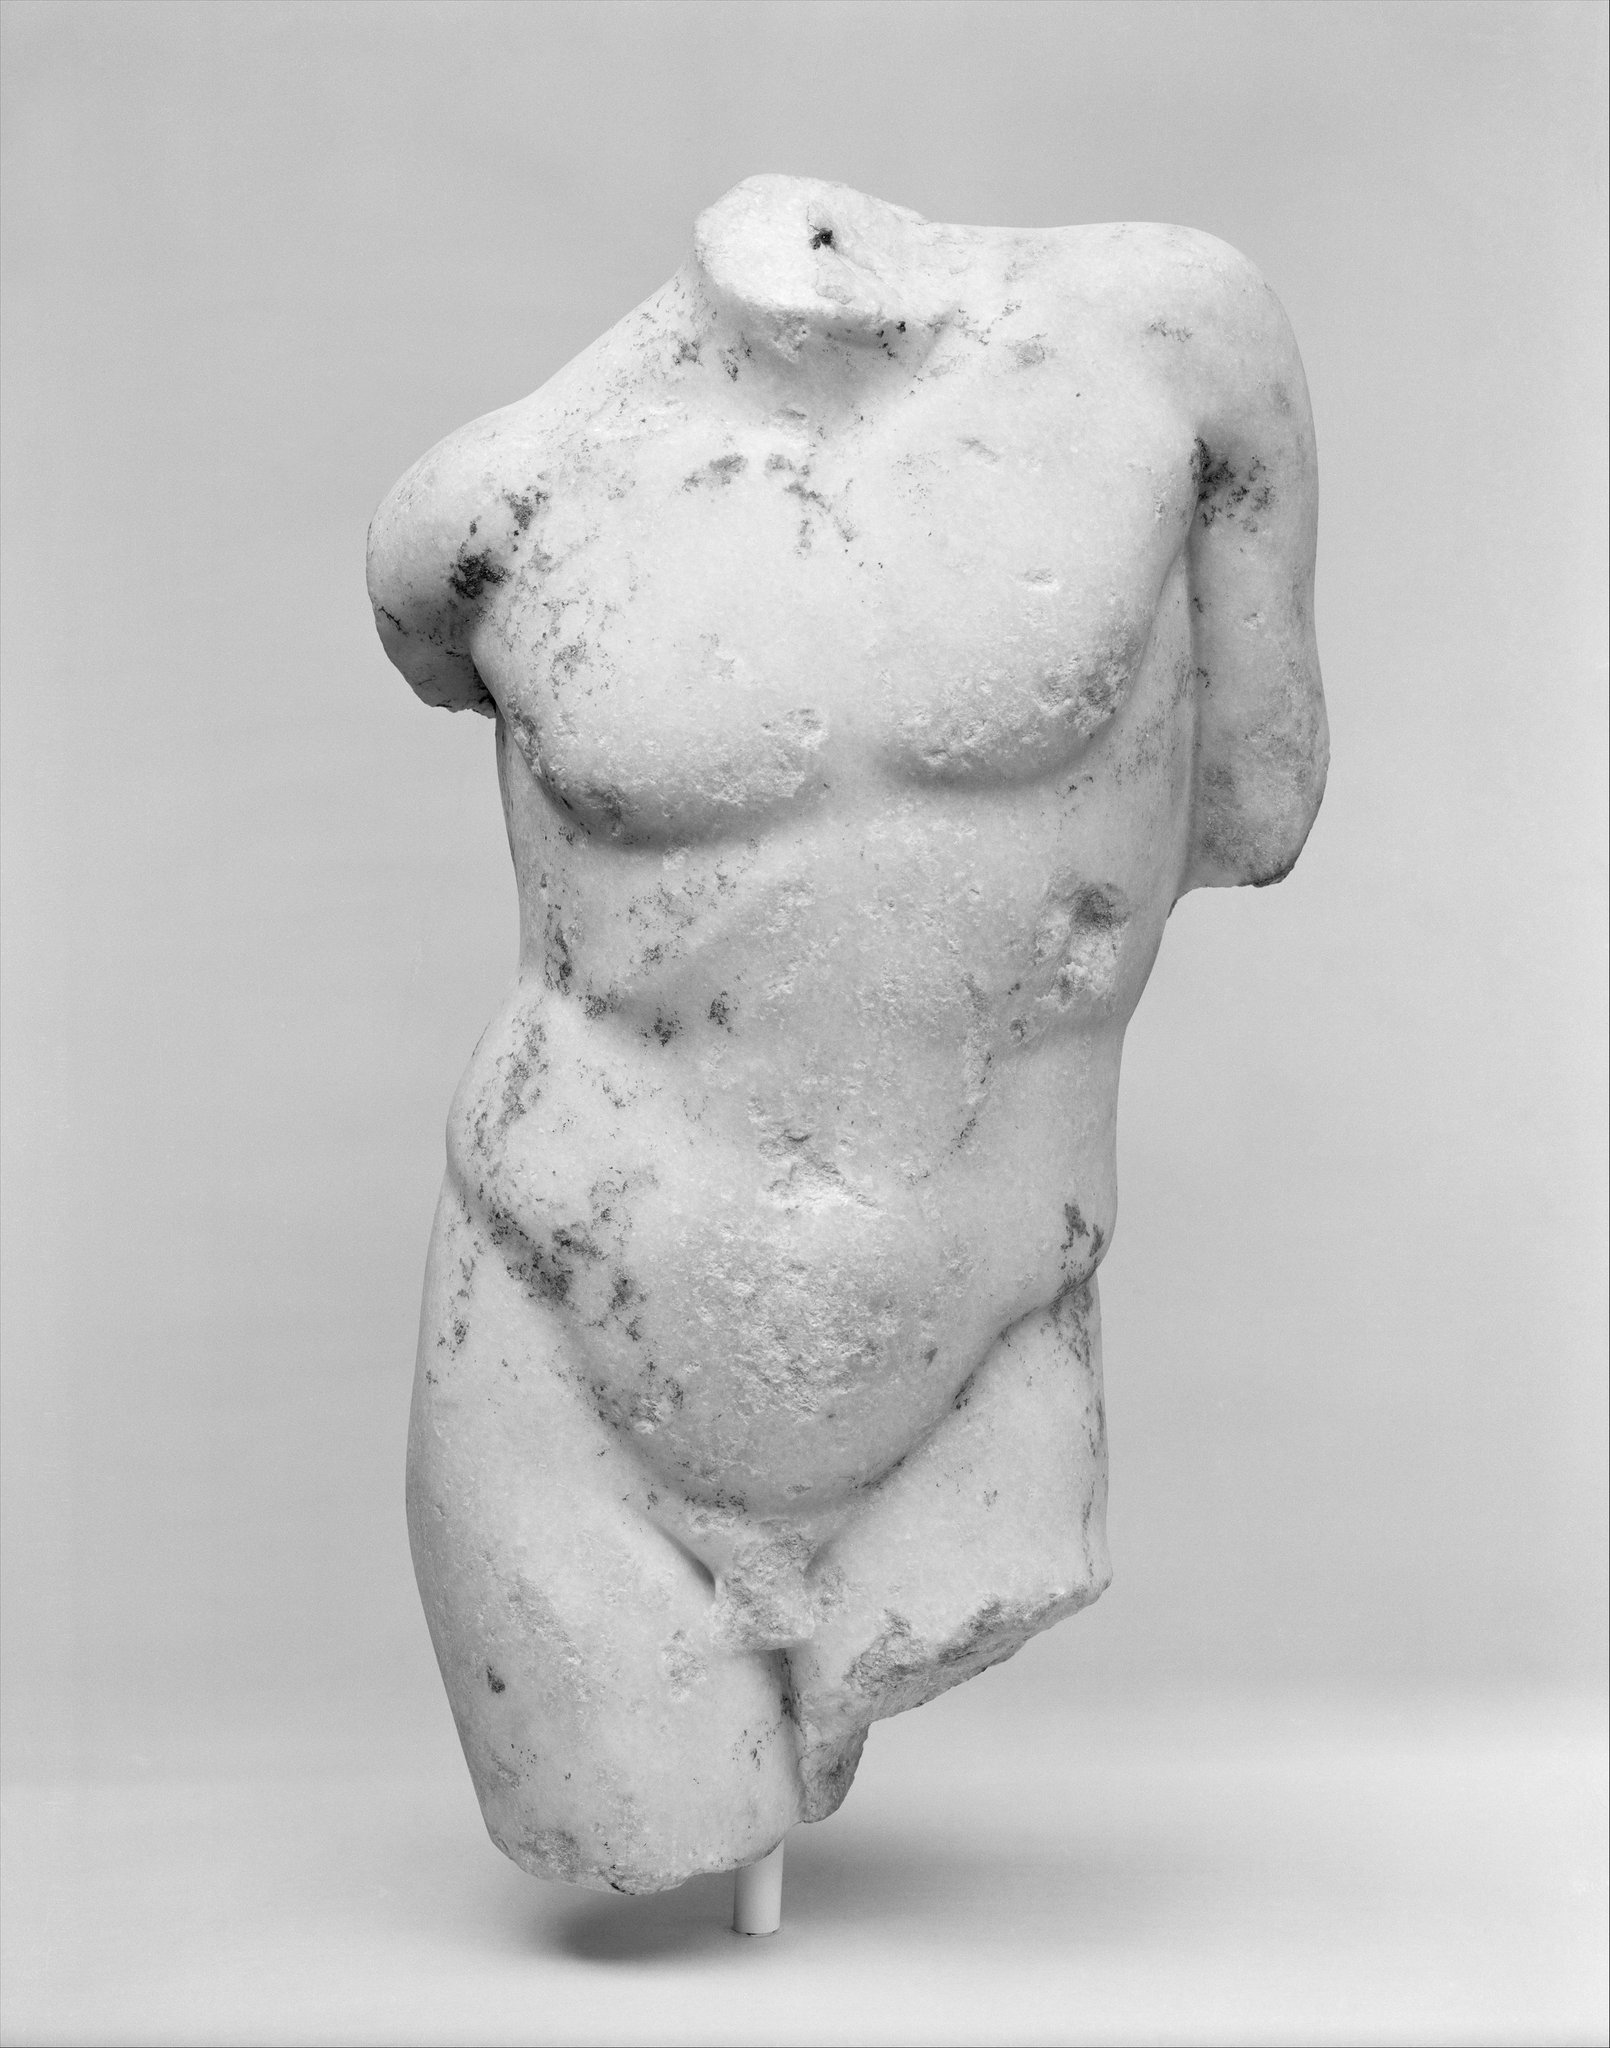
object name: torso of a boy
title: Marble torso of a boy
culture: roman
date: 1-200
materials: marble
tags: male nudes